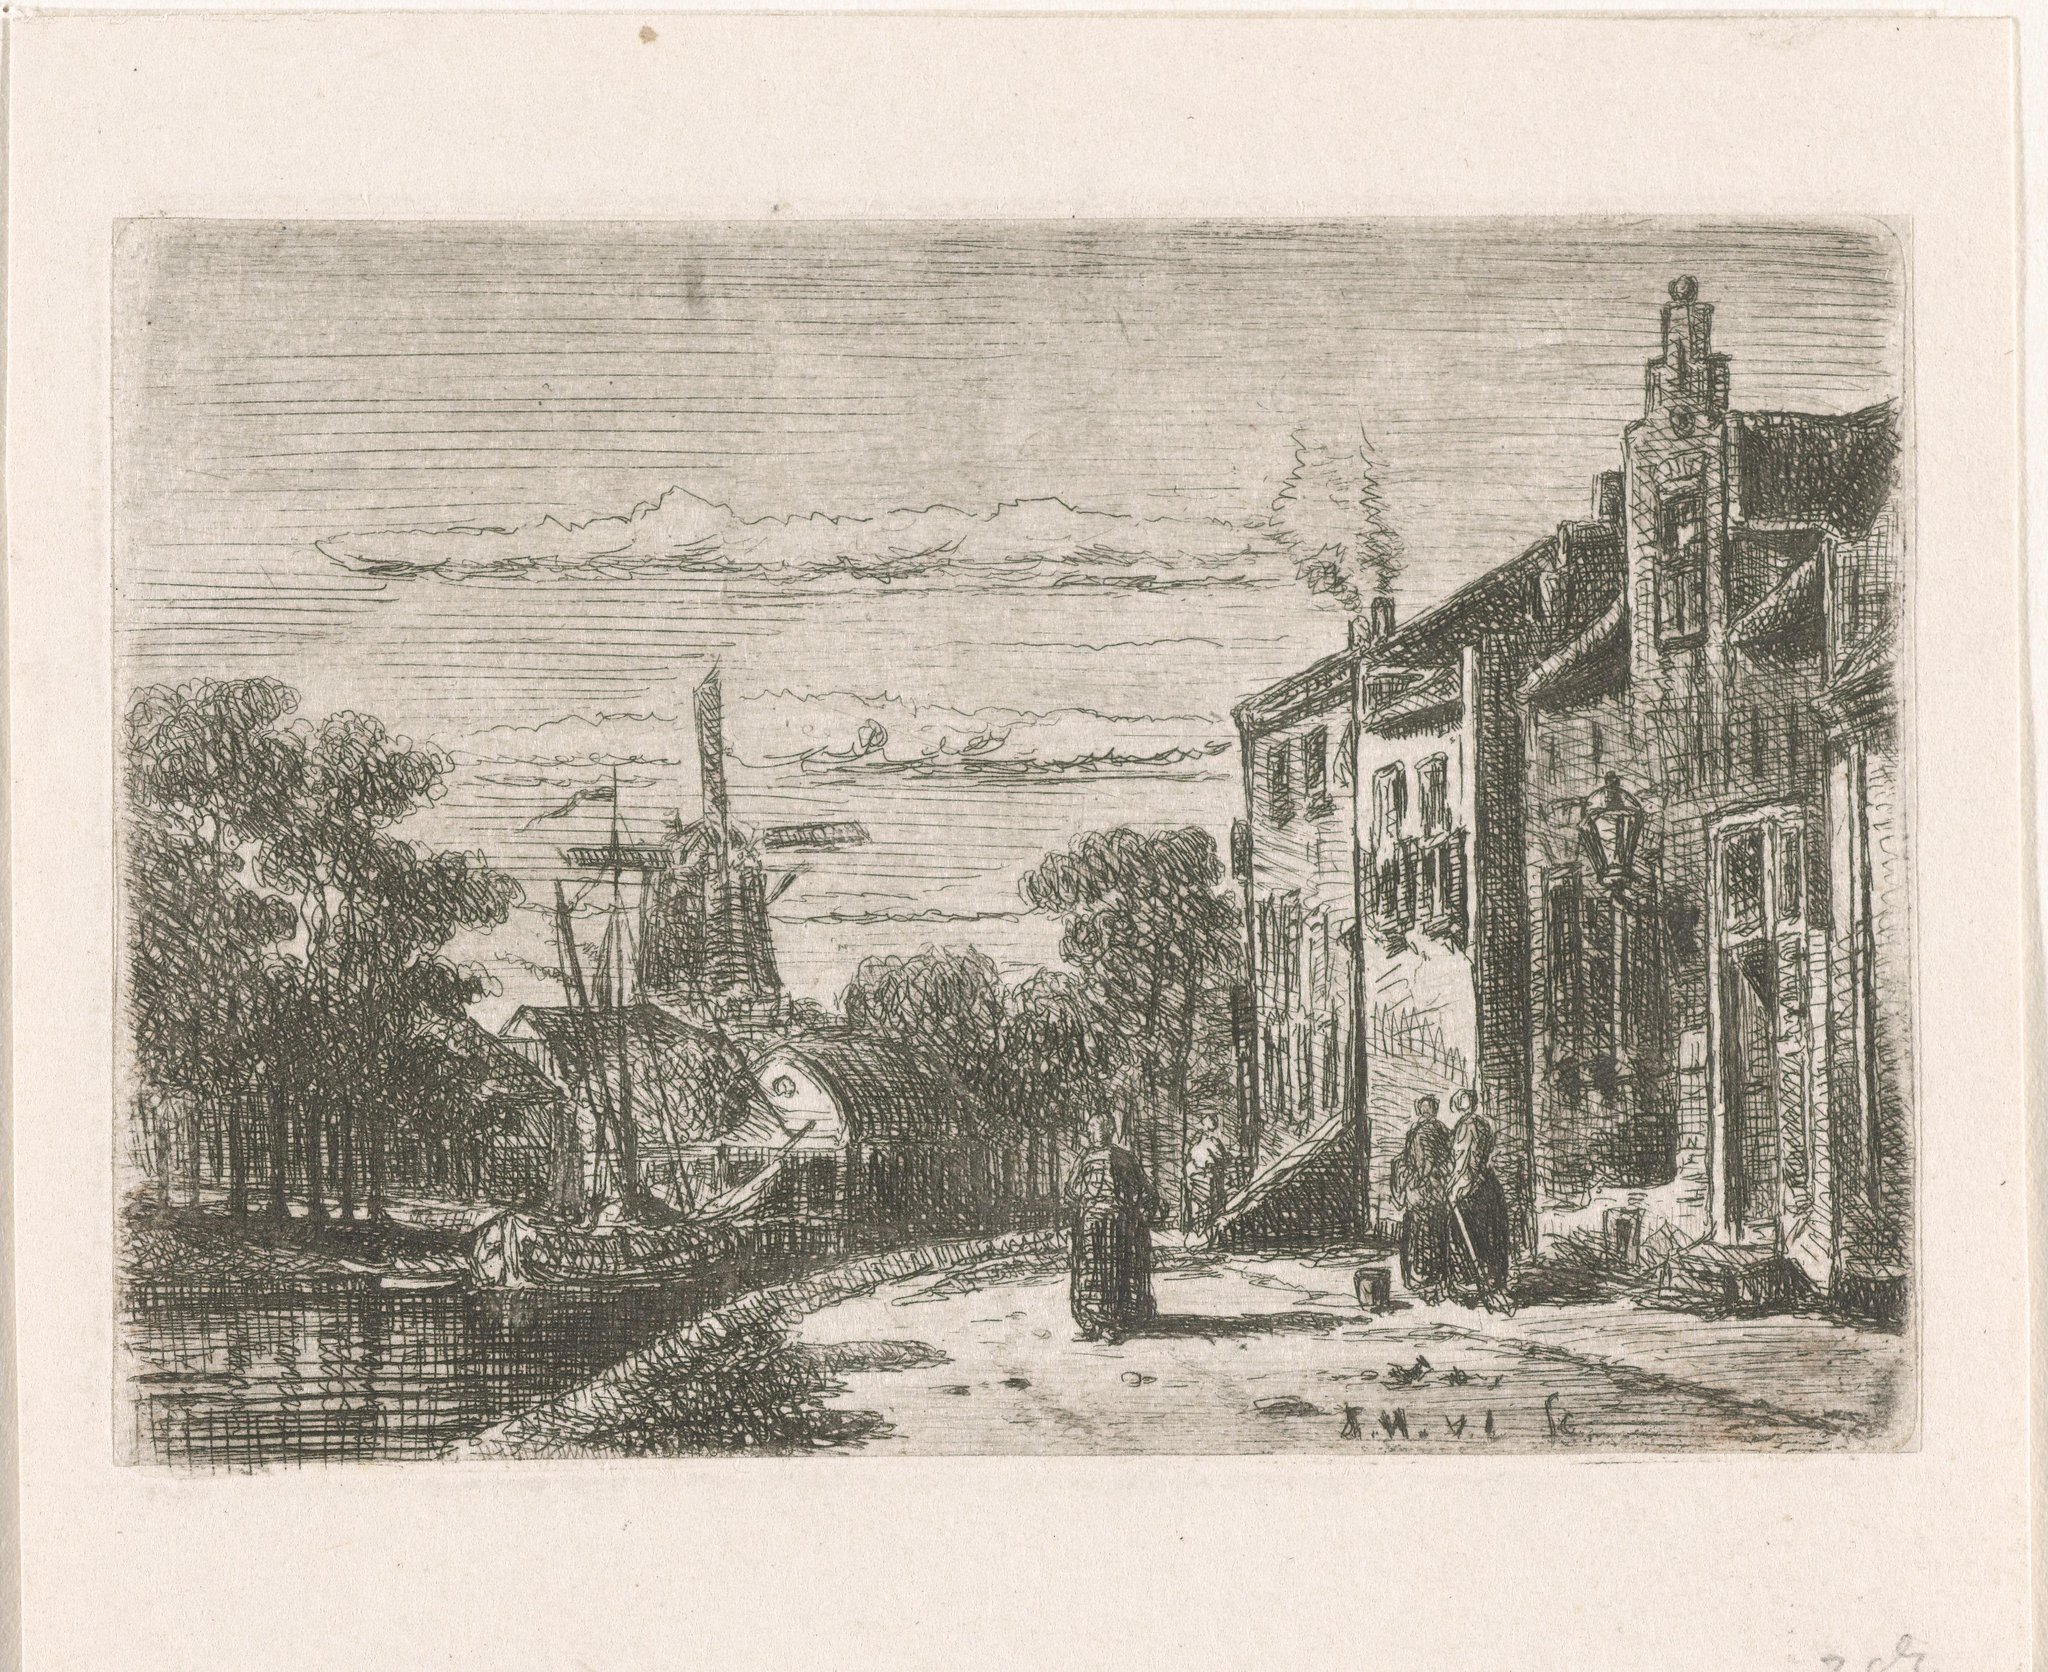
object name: print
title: Stadsgezicht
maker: jan van lokhorst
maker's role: draughtsman, print maker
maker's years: 1837-1894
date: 1847-1874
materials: paper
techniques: etching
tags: canals, waters (in city)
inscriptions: collector's mark: Lugt 2228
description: Stadsgezicht met huizen aan een gracht, in de verte een molen.